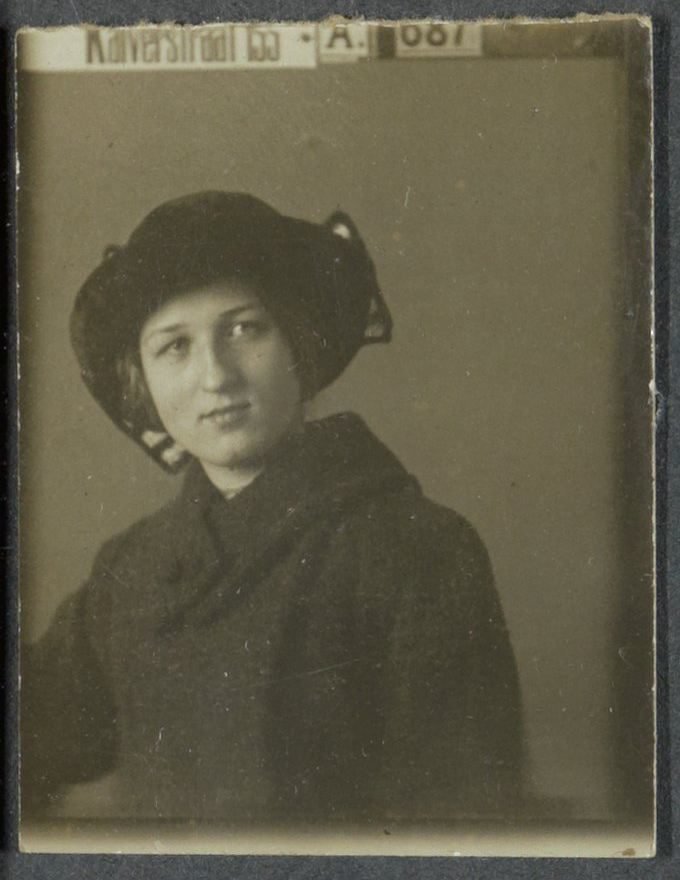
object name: snapshot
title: Portret van een vrouw met een hoed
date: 1913-1914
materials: paper, cardboard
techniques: gelatin silver print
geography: amsterdam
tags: adult woman, historical persons, head-gear: hat, amsterdam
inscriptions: address: ‘Kalverstraat 155’, number: ‘081’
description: Onderdeel van Fotoalbum met portretten vervaardigd door Nederlandse studio's waaronder automaatfoto's.